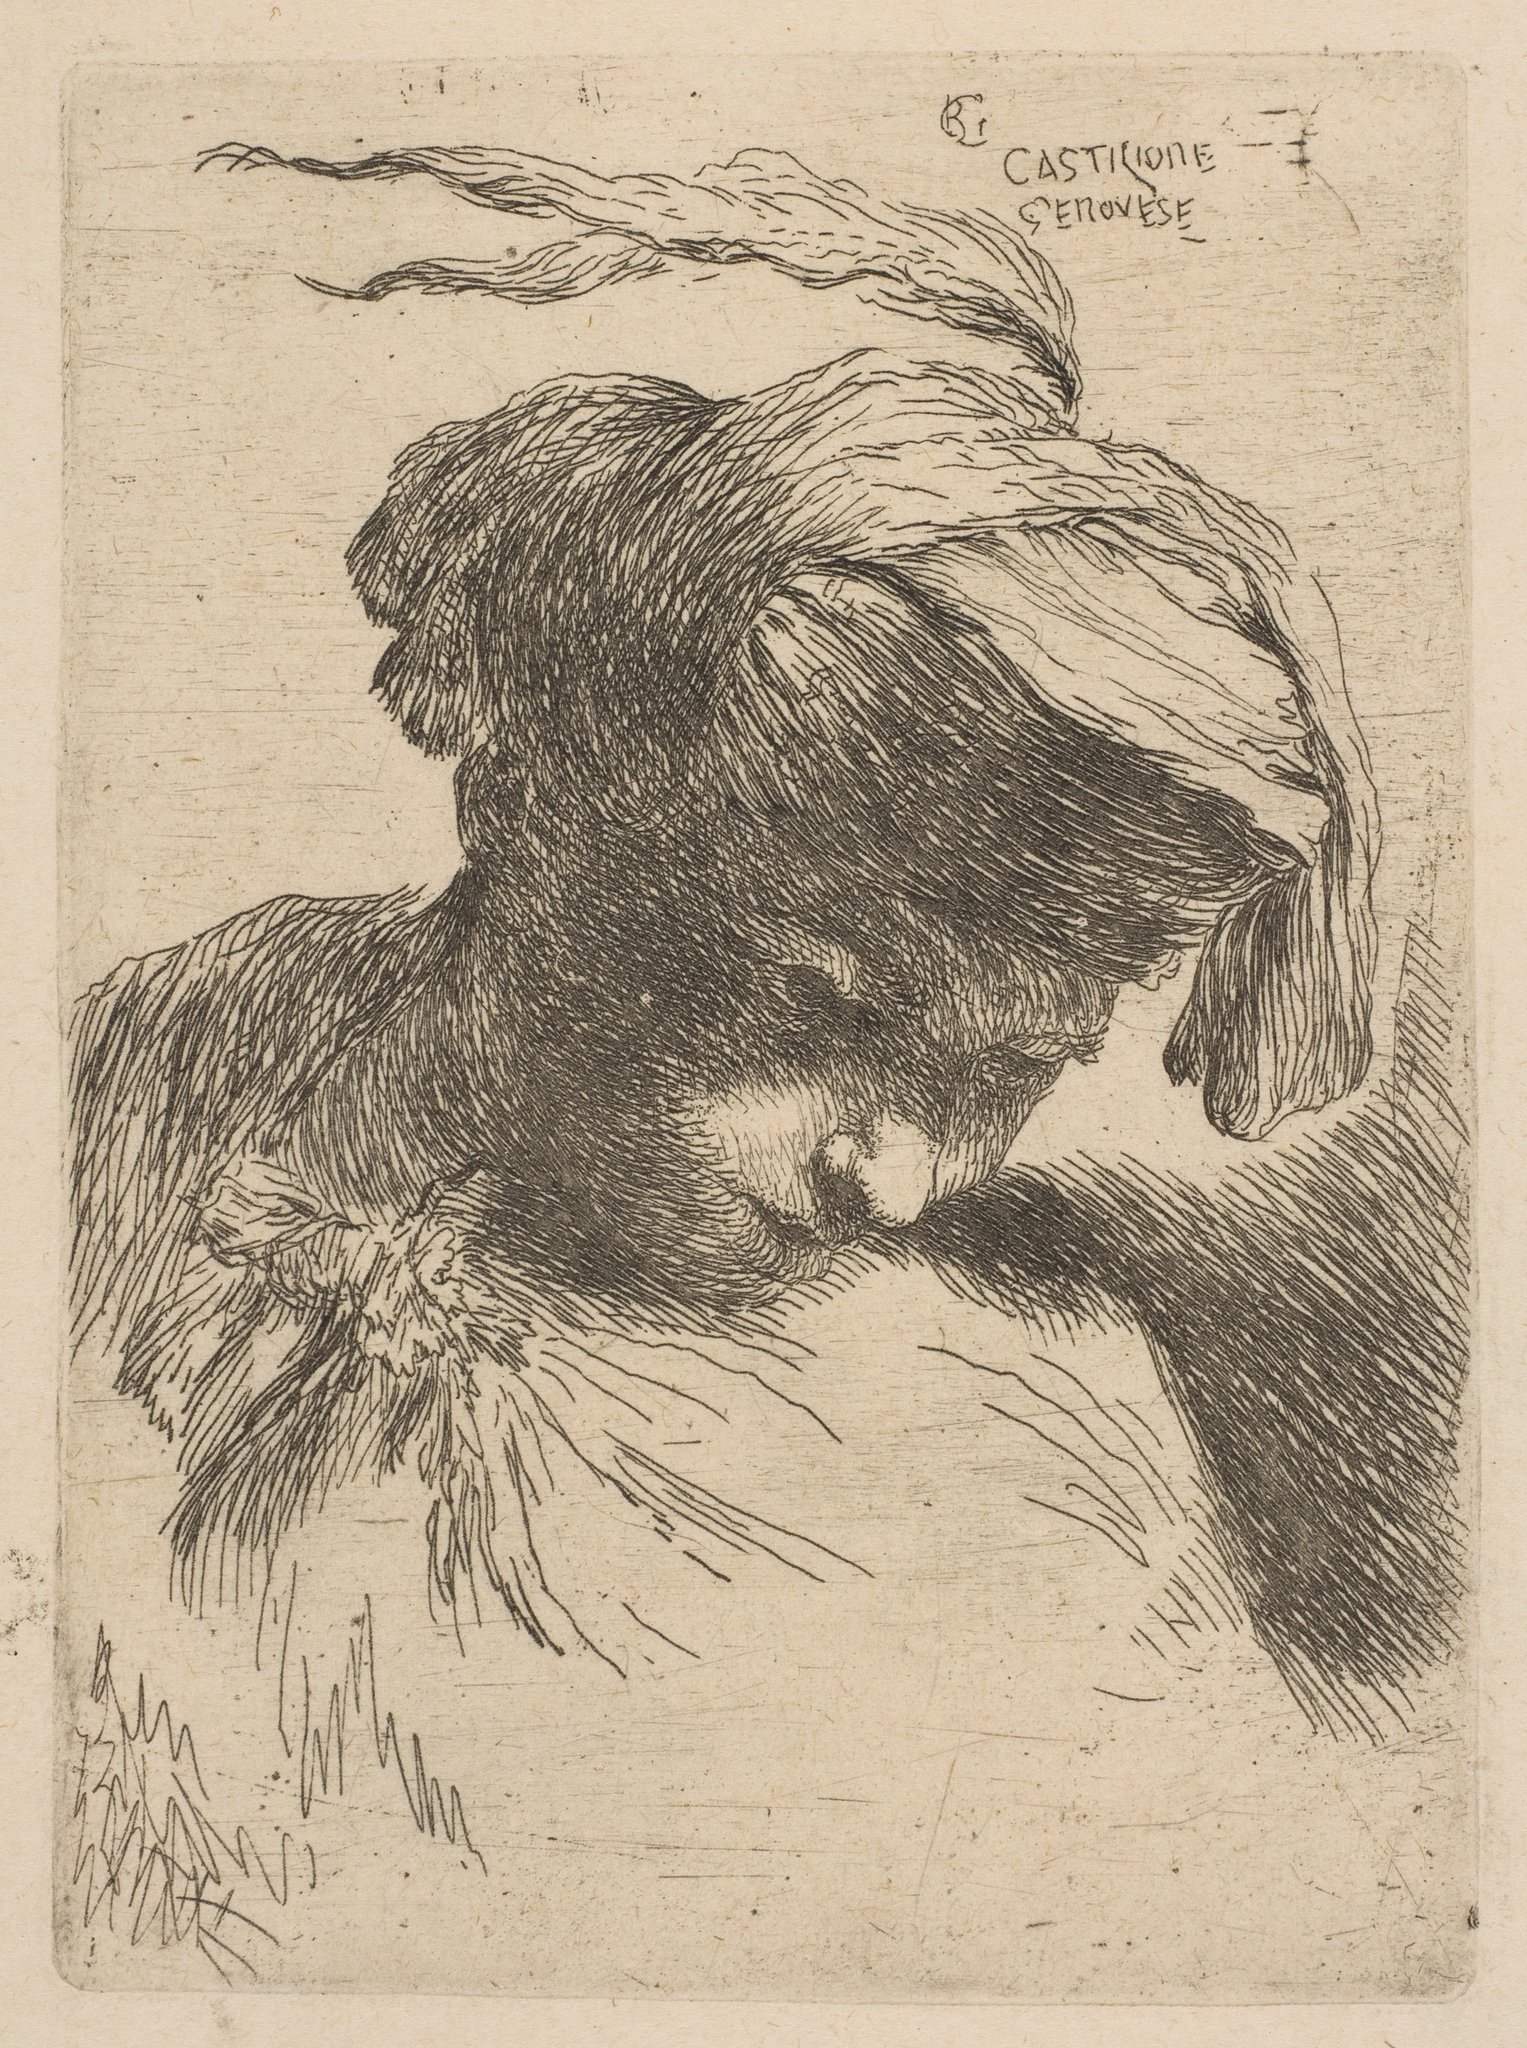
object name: print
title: Young man looking down to right, from "Small Heads in Oriental Headdress"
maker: giovanni benedetto castiglione (il grechetto)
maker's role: artist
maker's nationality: italian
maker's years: 1609-1664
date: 1645-1650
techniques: etching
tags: men